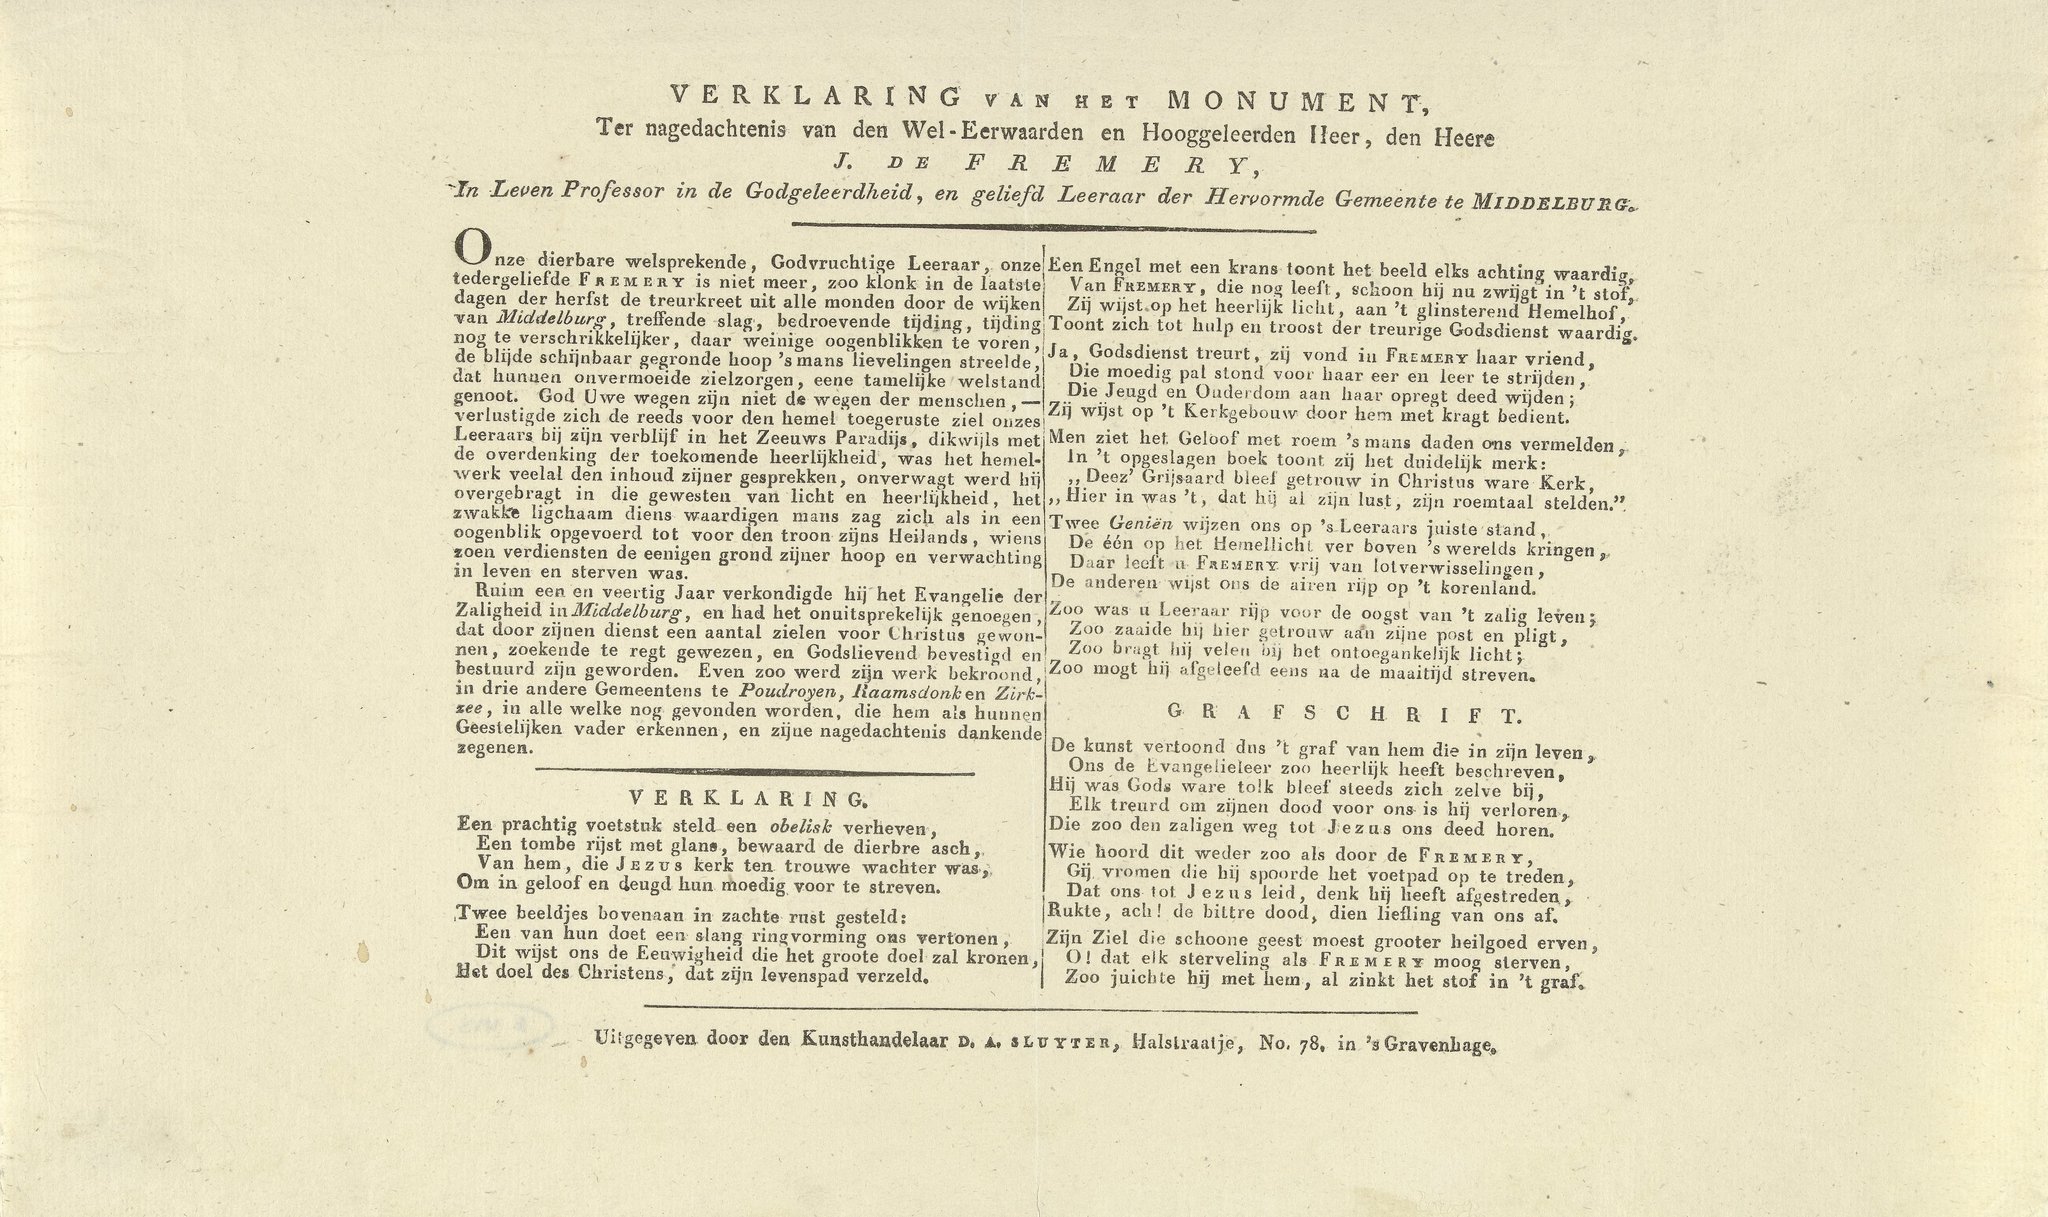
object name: text sheet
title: Verklaring van het monument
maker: d.a.m. sluyter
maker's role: publisher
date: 1819-1821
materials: paper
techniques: letterpress printing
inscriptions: collector's mark: Lugt 2228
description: Twee kolommen verklarende tekst bij het door Walraad Nieuwhoff in prent gebrachte gedenkteken voor de in 1819 overleden Joannes de Fremery, hoogleraar en predikant te Middelburg.